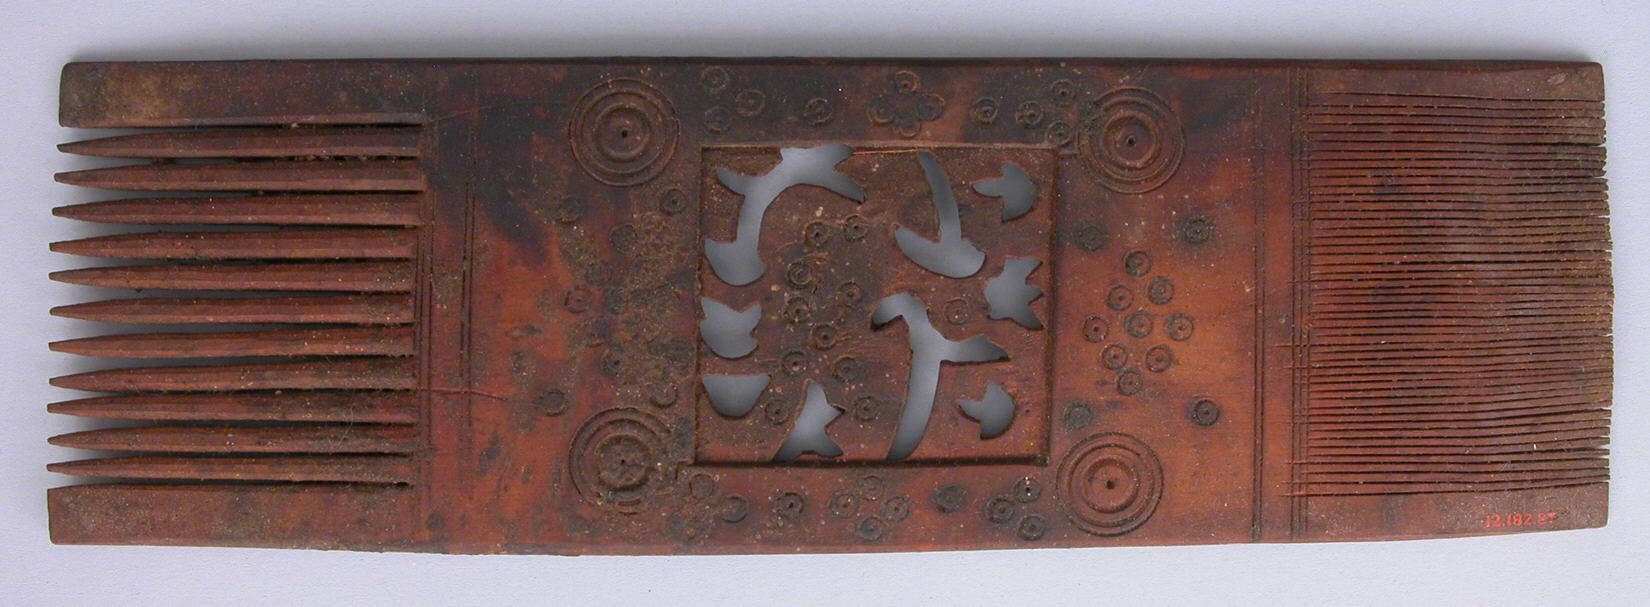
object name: comb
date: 601-800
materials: wood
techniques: carving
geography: egypt